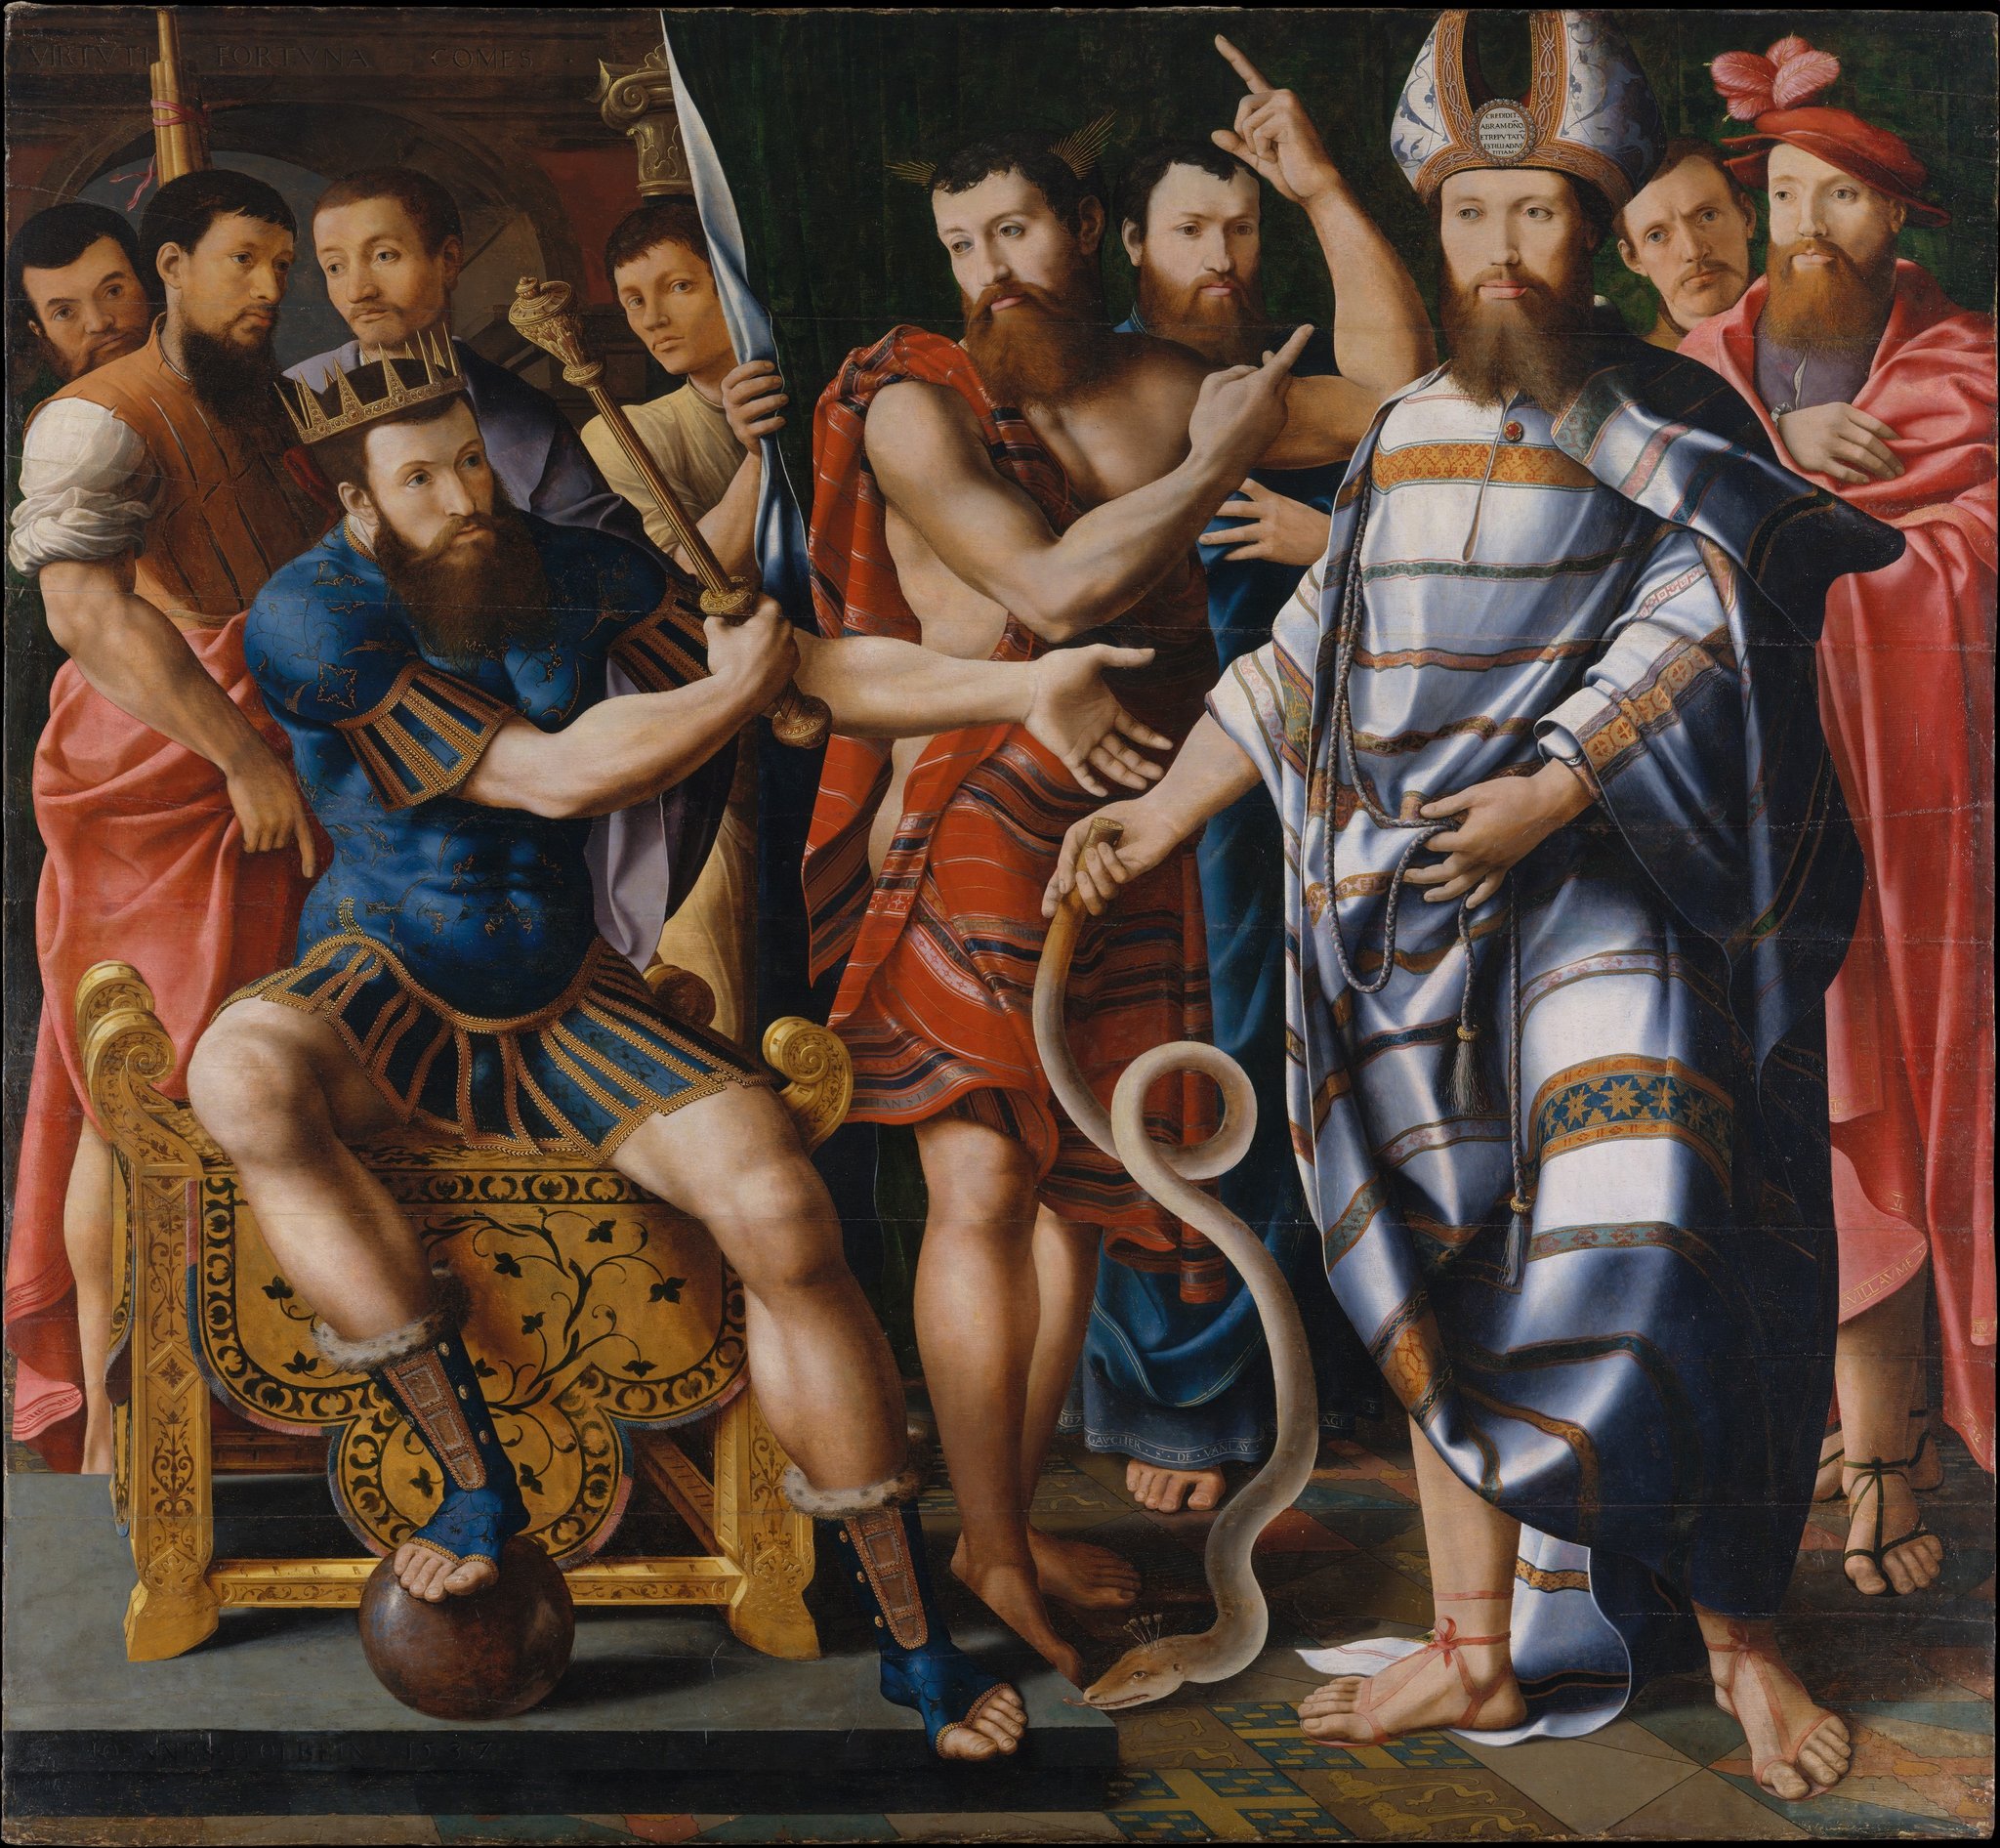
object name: painting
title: Moses and Aaron before Pharaoh: An Allegory of the Dinteville Family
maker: master of the dinteville allegory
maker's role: artist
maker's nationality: netherlandish, french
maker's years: 1525-1575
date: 1537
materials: oil, wood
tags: men,serpents,moses,aaron